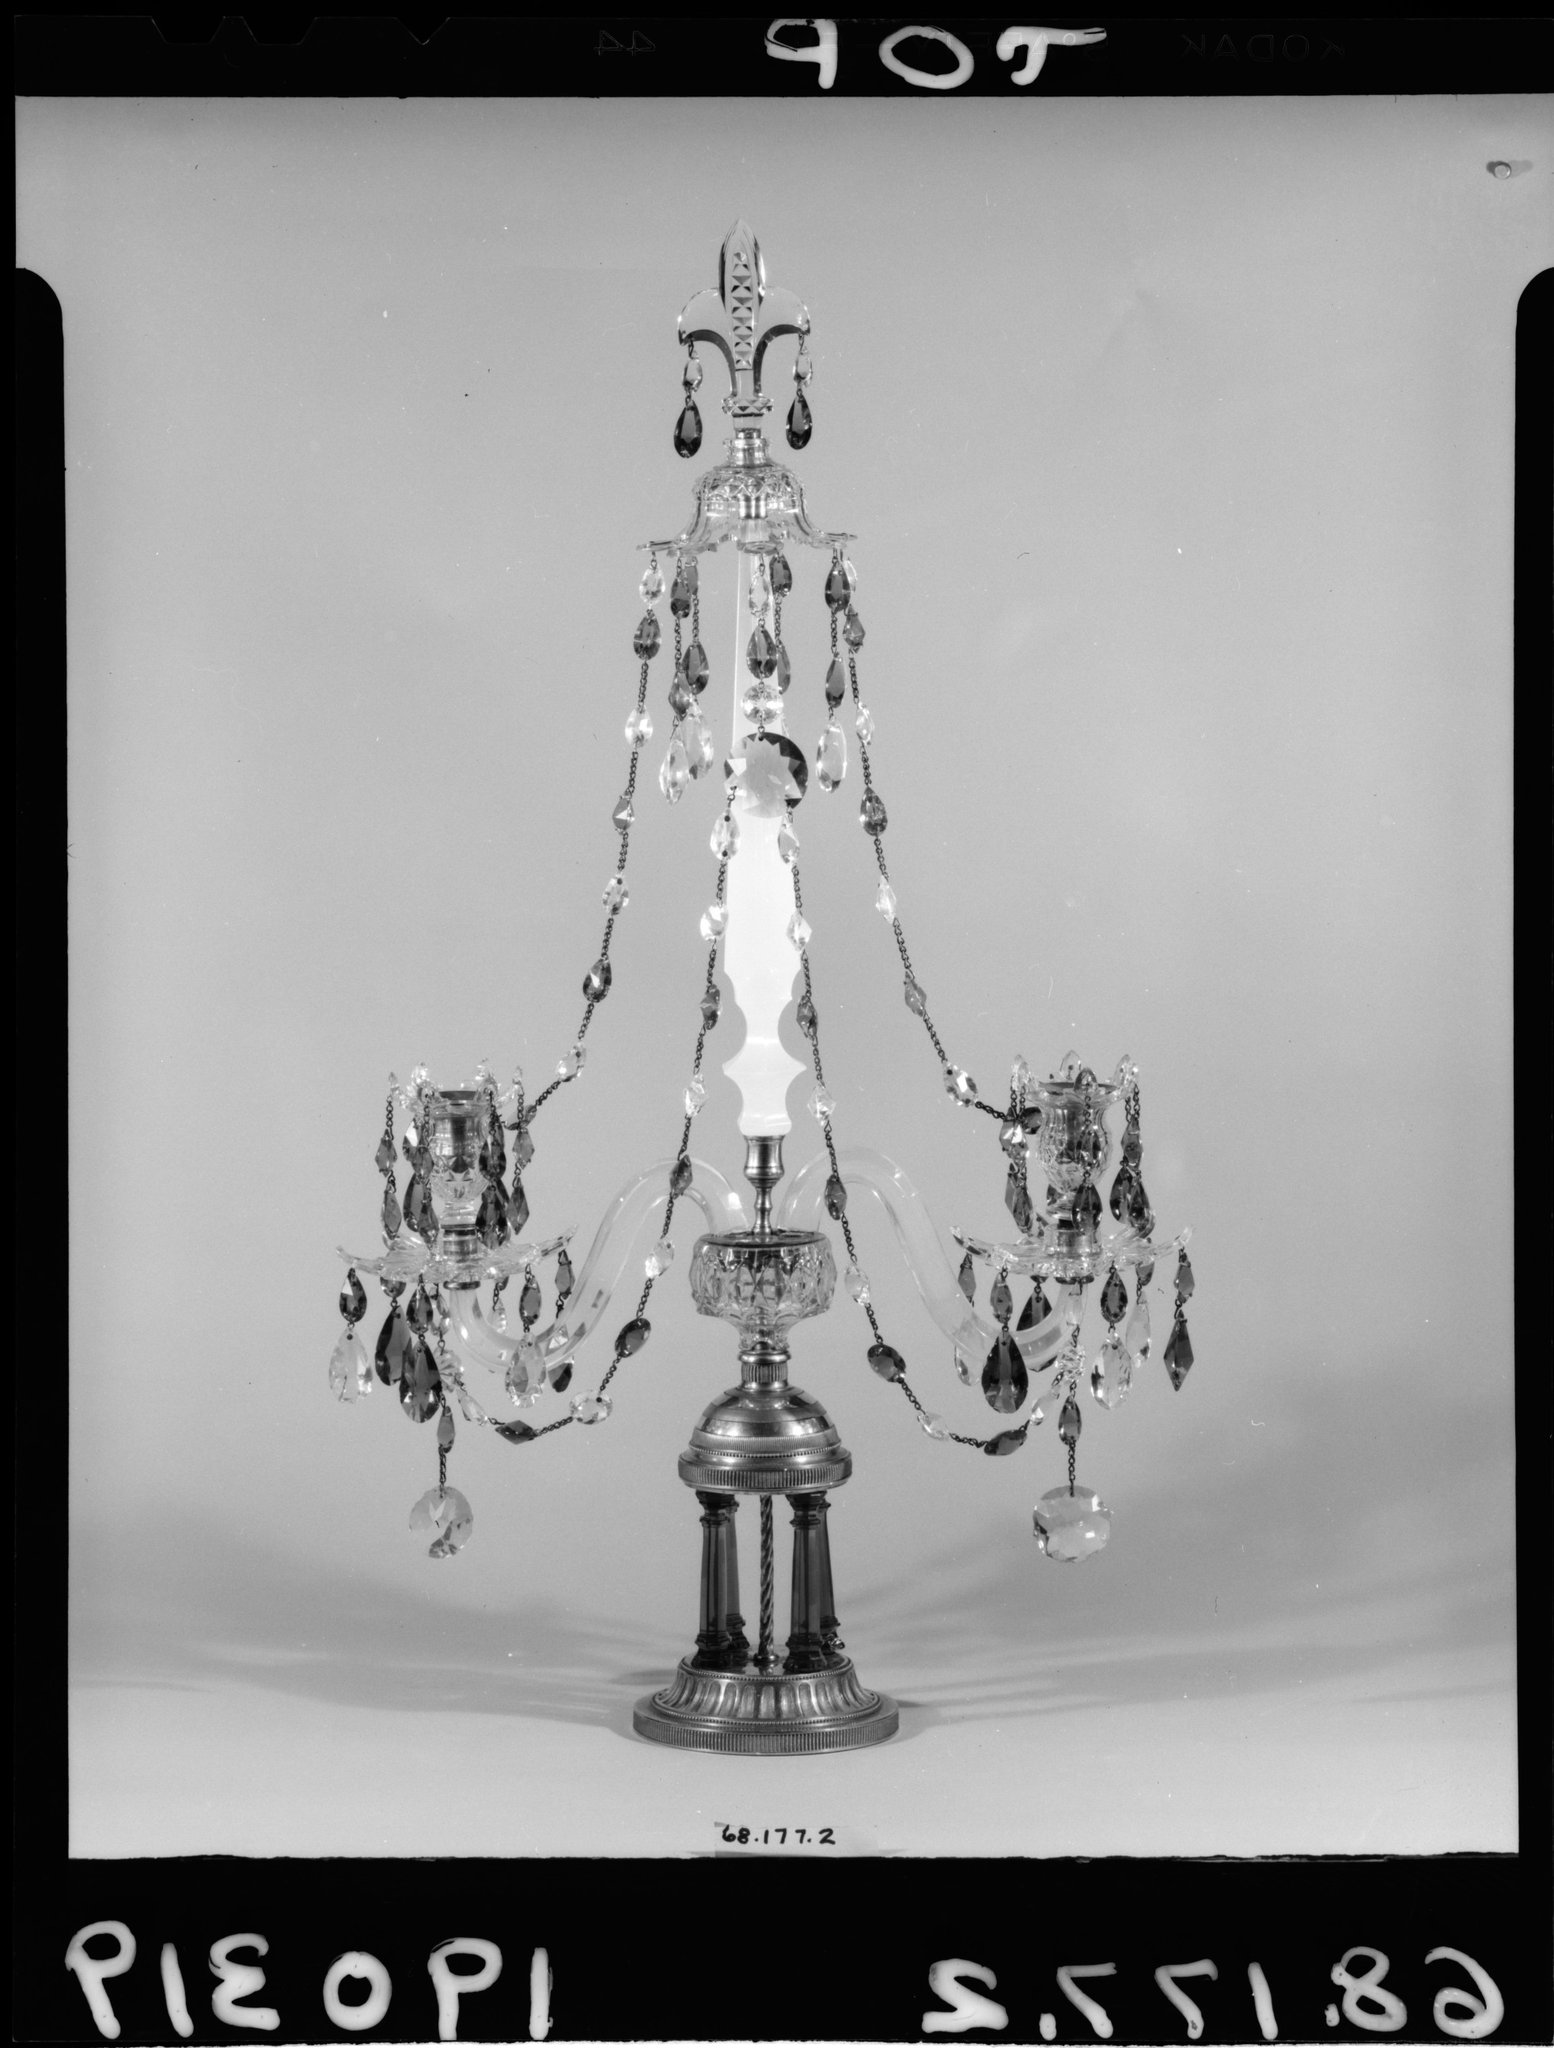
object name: candelabrum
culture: british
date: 1795-1810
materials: gemstone, gilt bronze, glass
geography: england